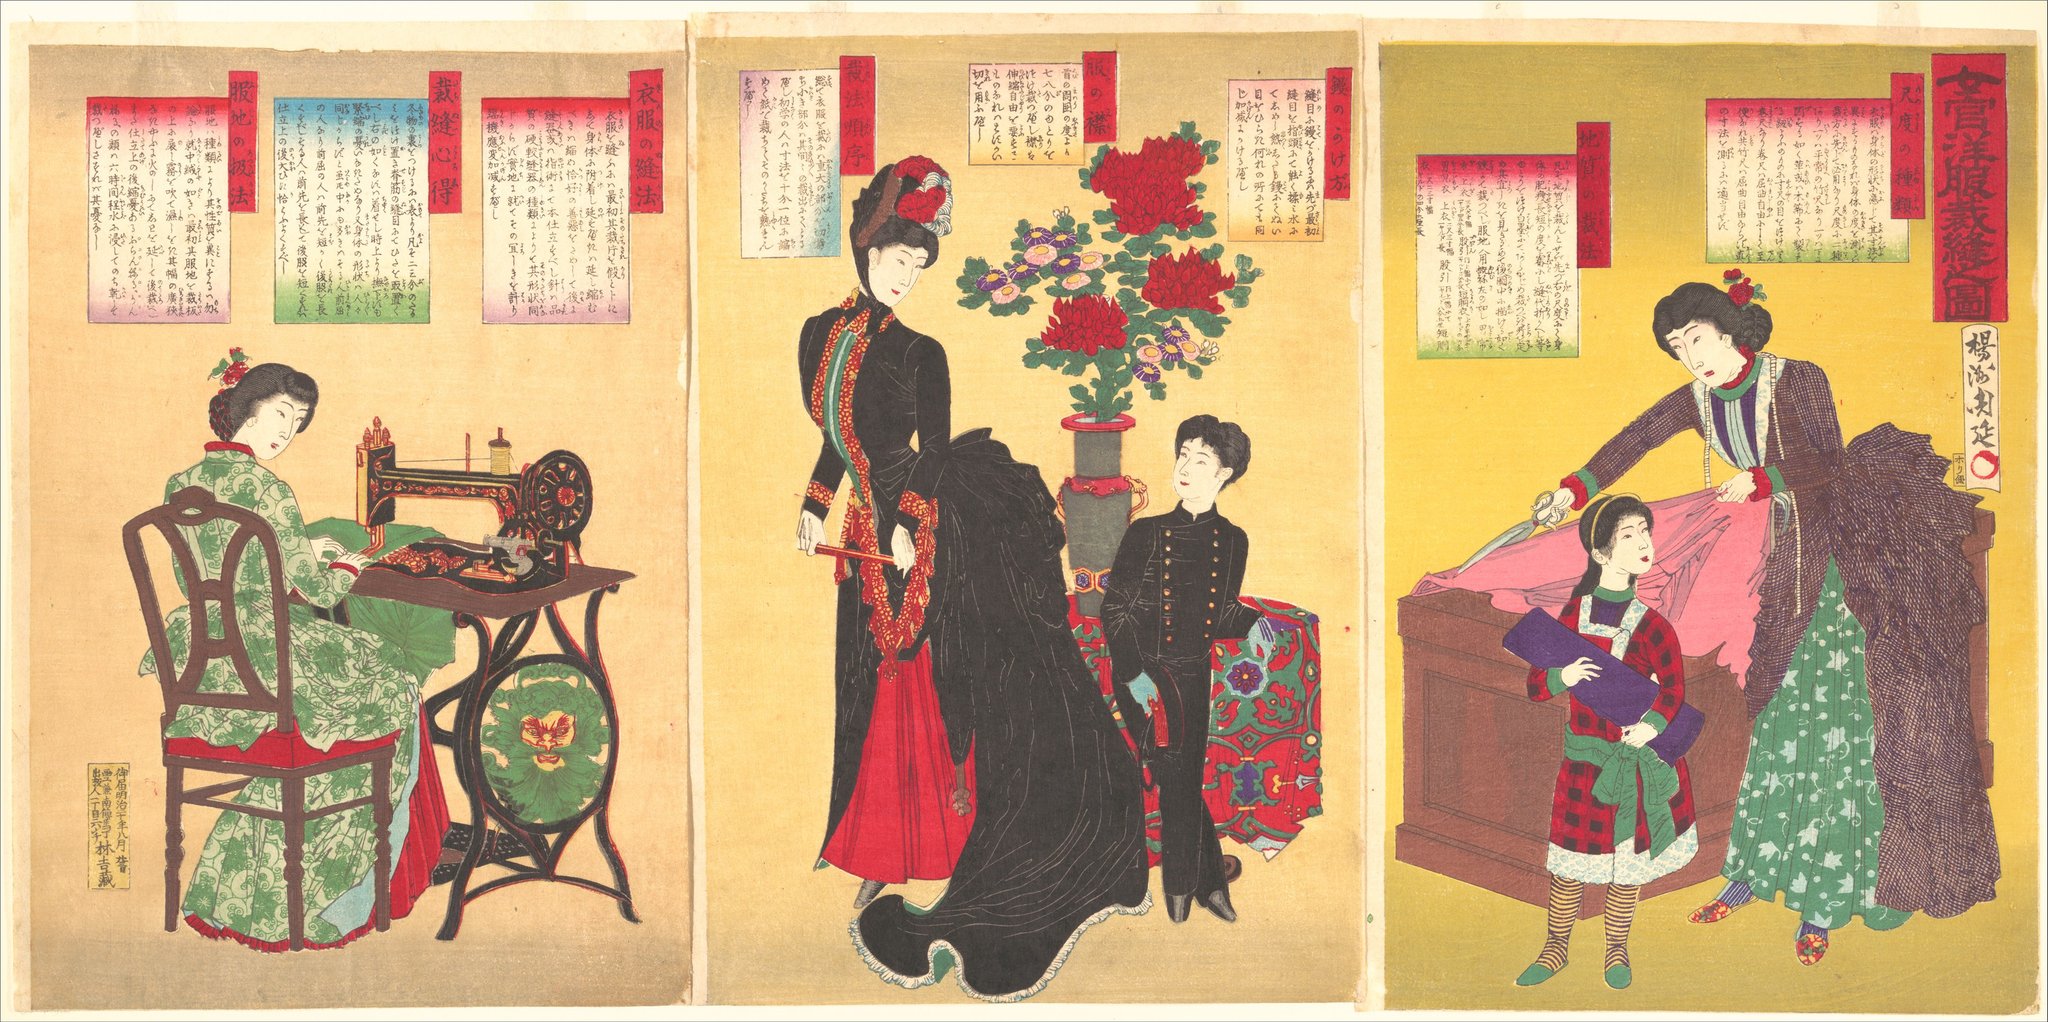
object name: woodblock print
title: Court Ladies Sewing Western Clothing (Jokan yōfuku saihō no zu)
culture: japanese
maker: yōshū (hashimoto) chikanobu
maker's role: artist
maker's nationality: japanese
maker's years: 1838-1912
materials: ink, paper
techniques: nishiki e, woodblock print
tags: boys,girls,women,sewing